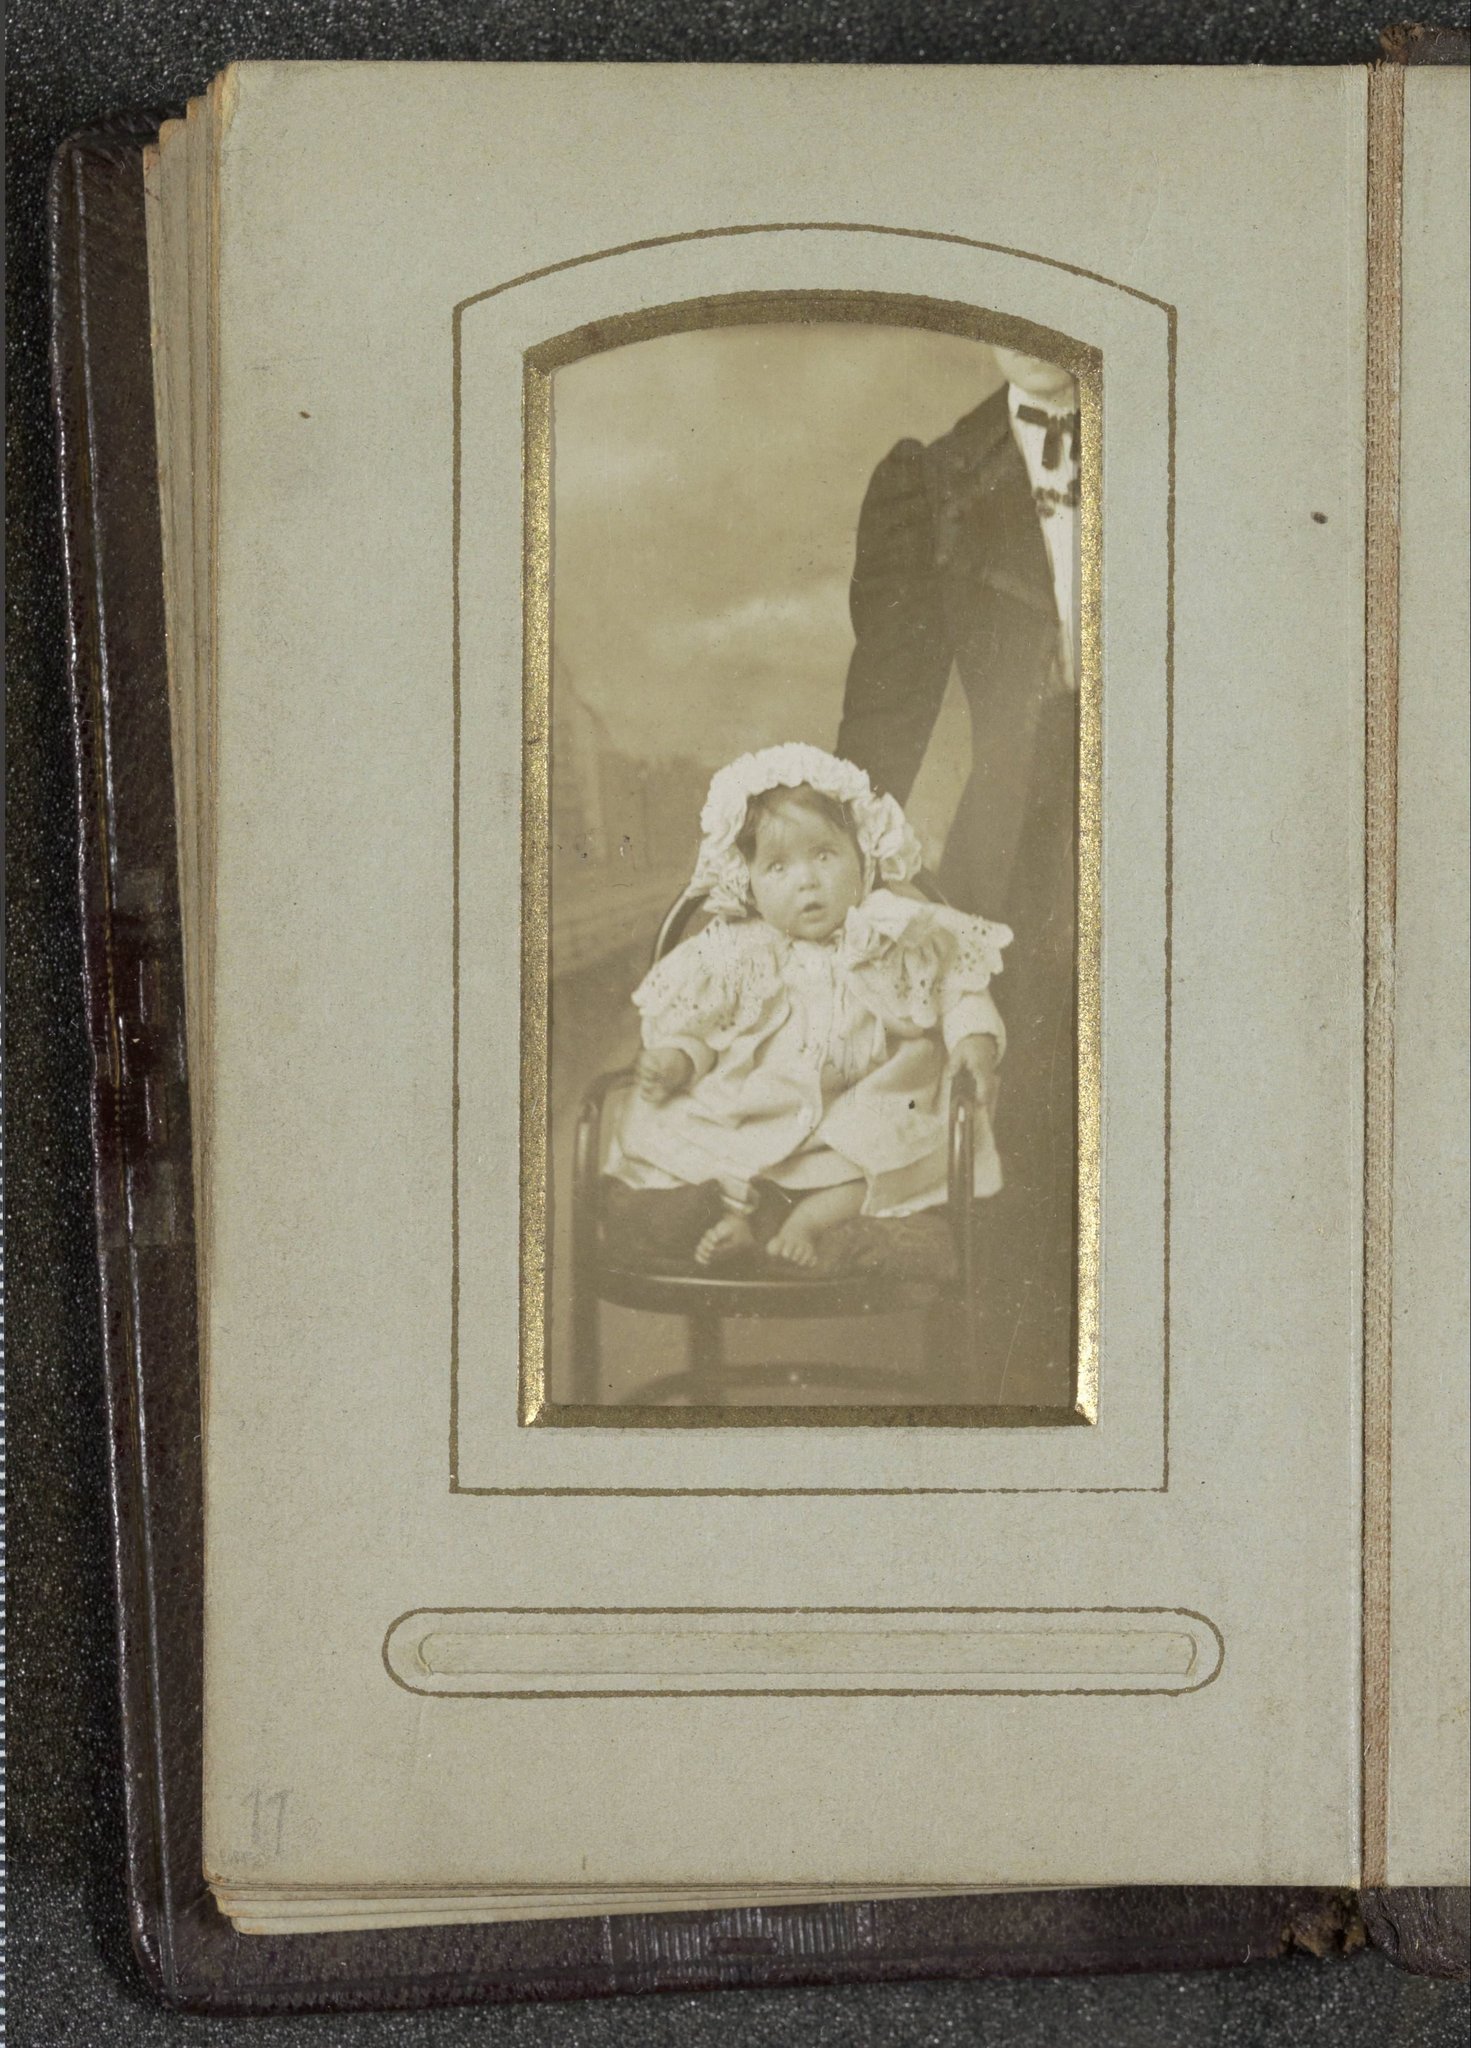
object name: photograph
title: Portret van een baby met een muts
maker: Anonymous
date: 1890-1910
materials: cardboard, paper, photographic support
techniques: gelatin silver print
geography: england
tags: head-gear: cap, mother and baby or young child, england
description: Onderdeel van Album met 12 automaatfoto's van een Engelse familie.